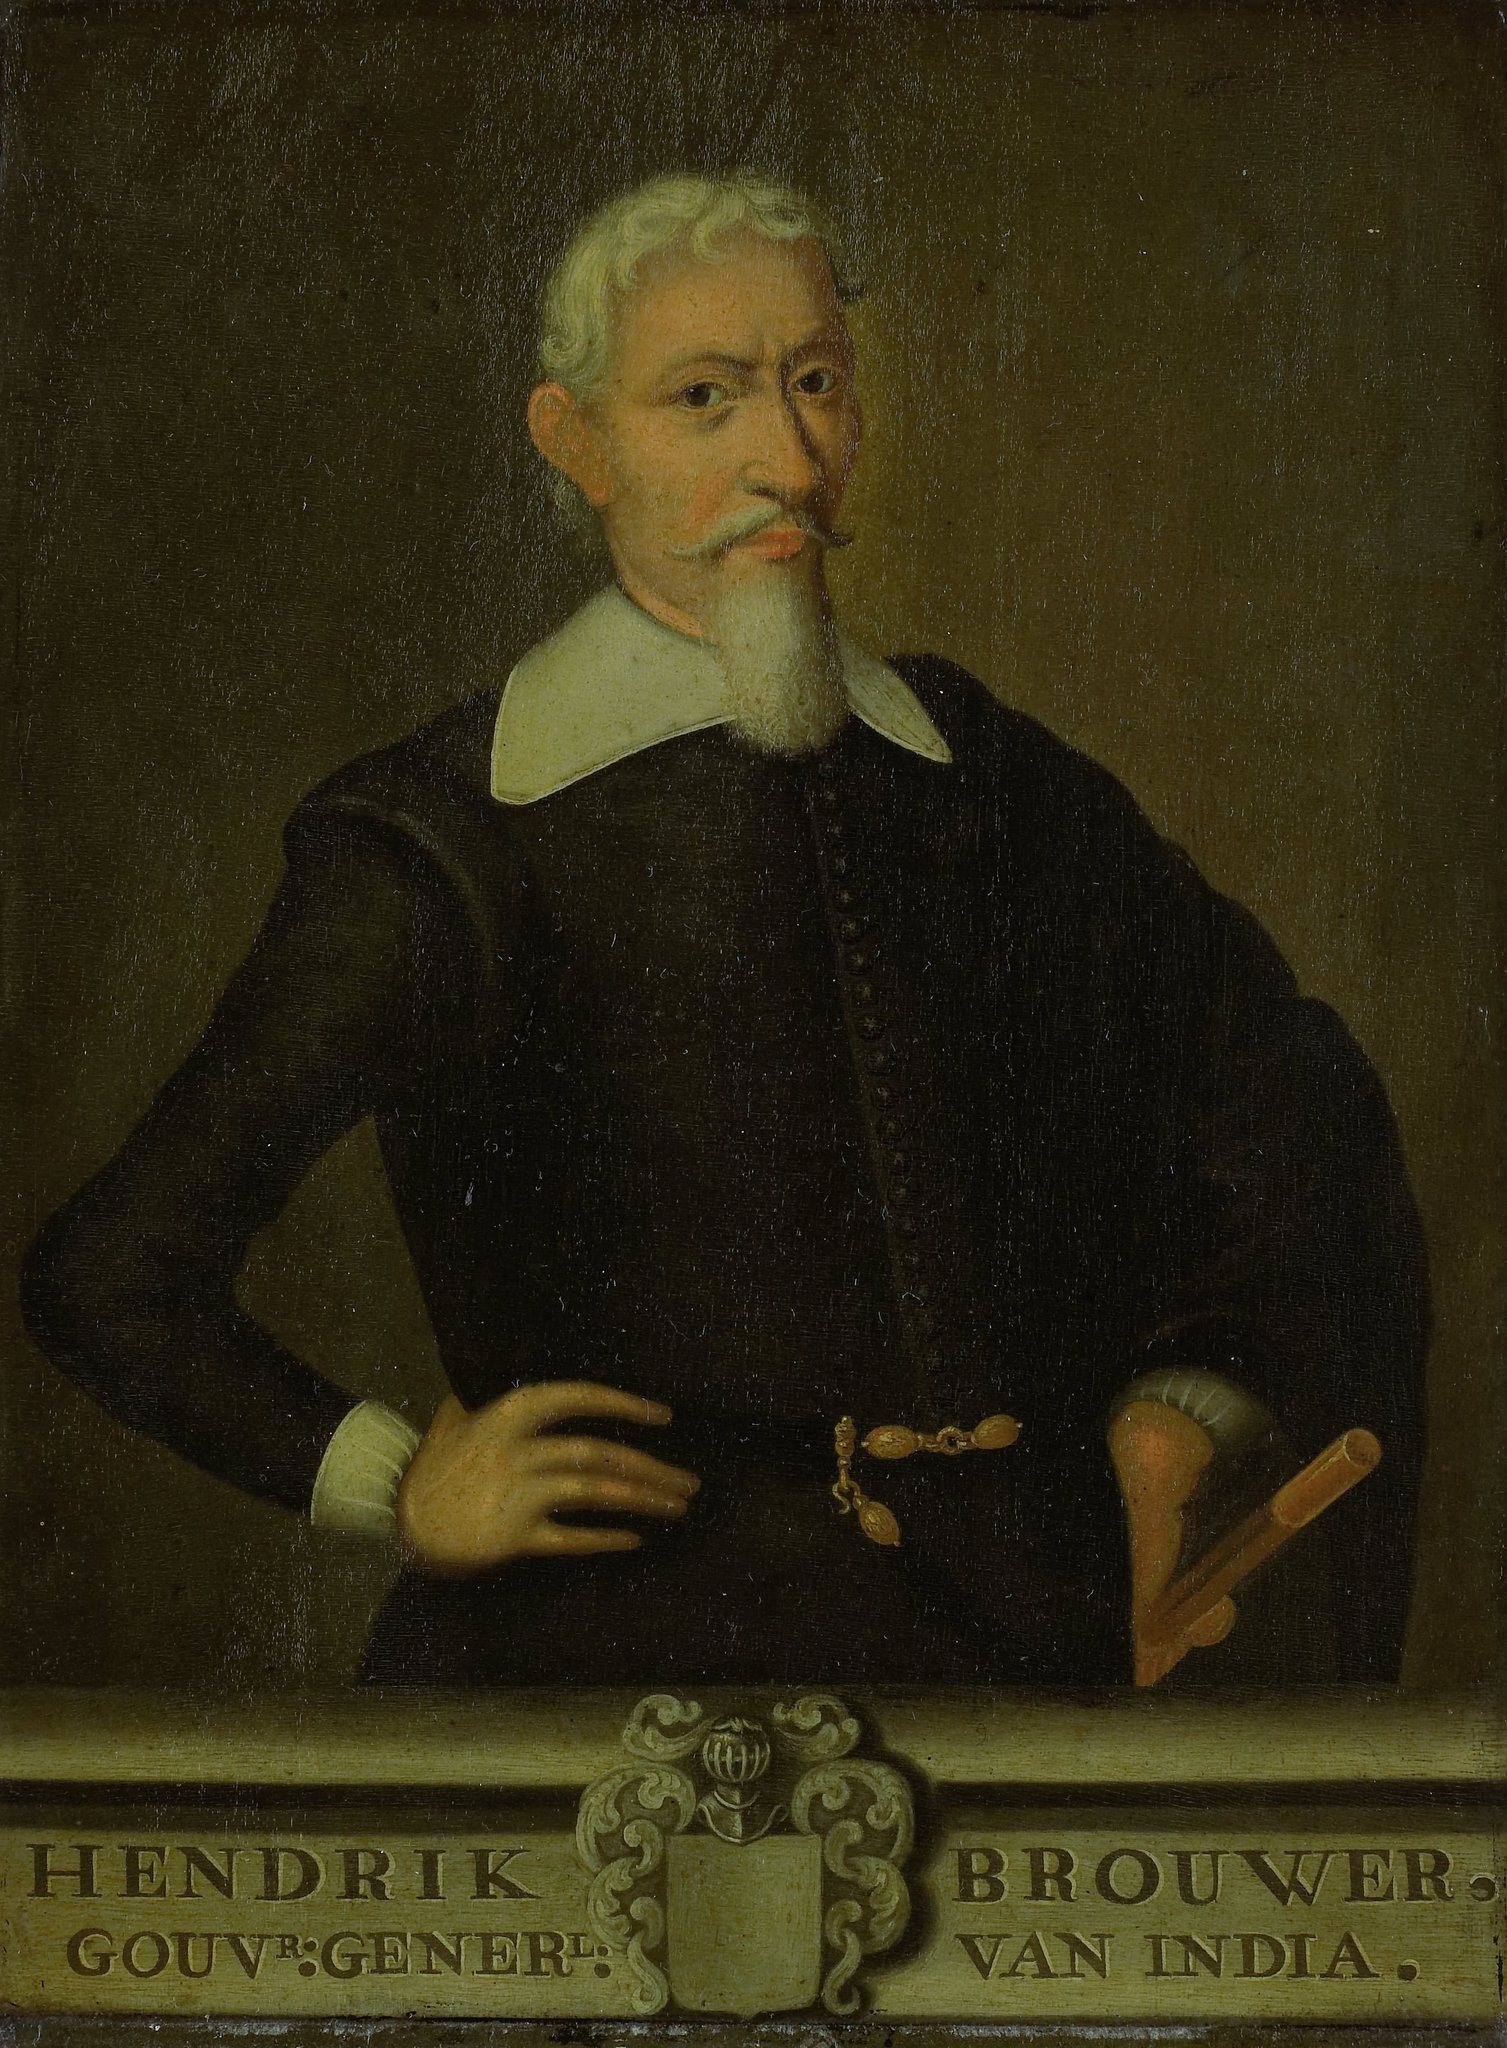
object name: painting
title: Portrait of Hendrik Brouwer, Governor-General of the Dutch East Indies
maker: Anonymous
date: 1750-1800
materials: oil, panel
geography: netherlands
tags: verenigde oostindische compagnie, gouverneur-generaal, hendrik brouwer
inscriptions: inscription: ‘Hendrik Brouwer, Gouv.r Gener.l van India.’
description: Portraits of the governors general. At the head of the VOC administration in Asia was the governor general, the chairman of the East Indies Council, which met in Batavia. The Council's assembly chamber at the Castle in Batavia was the focal point of Dutch power. Along the walls hung the portraits of all the past governors general, symbolising the continuity of the Dutch presence. Smaller copies at the Company's offices in the Netherlands represented the VOC's power in Asia. The copies displayed here probably come from the VOC's Rotterdam Chamber. Some of the portraits from the series that hung in Batavia are displayed above in the VOC gallery that circles this room. Pieter Both, 1610-1614 Gerard Reynst, 1614-1615 Laurens Reael,1615-1619 Jan Pietersz Coen, 1619-1623 and 1627-1629 Pieter de Carpentier, 1623-1627 Jacques Specx, 1629-1632 Hendrick Brouwer, 1632-1636 Antonio van Diemen, 1636-1645 Cornelis van der Lijn, 1645-1650 Karel Reiniersz, 1650-1653 Joan Maetsuycker, 1653-1678 Rycklof van Goens, 1678-1681 Cornelis Speelman, 1681-1684 Johannes Camphuys, 1684-1691 Willem van Outshoorn, 1691-1704 Abraham van Riebeeck, 1709-1713 Christoffel van Swoll, 1713-1718 Hendrick Zwaardecroon, 1718-1725 Mattheus de Haan, 1725-1729 The portrait of Joan van Hoorn, 1704-1709, is missing.